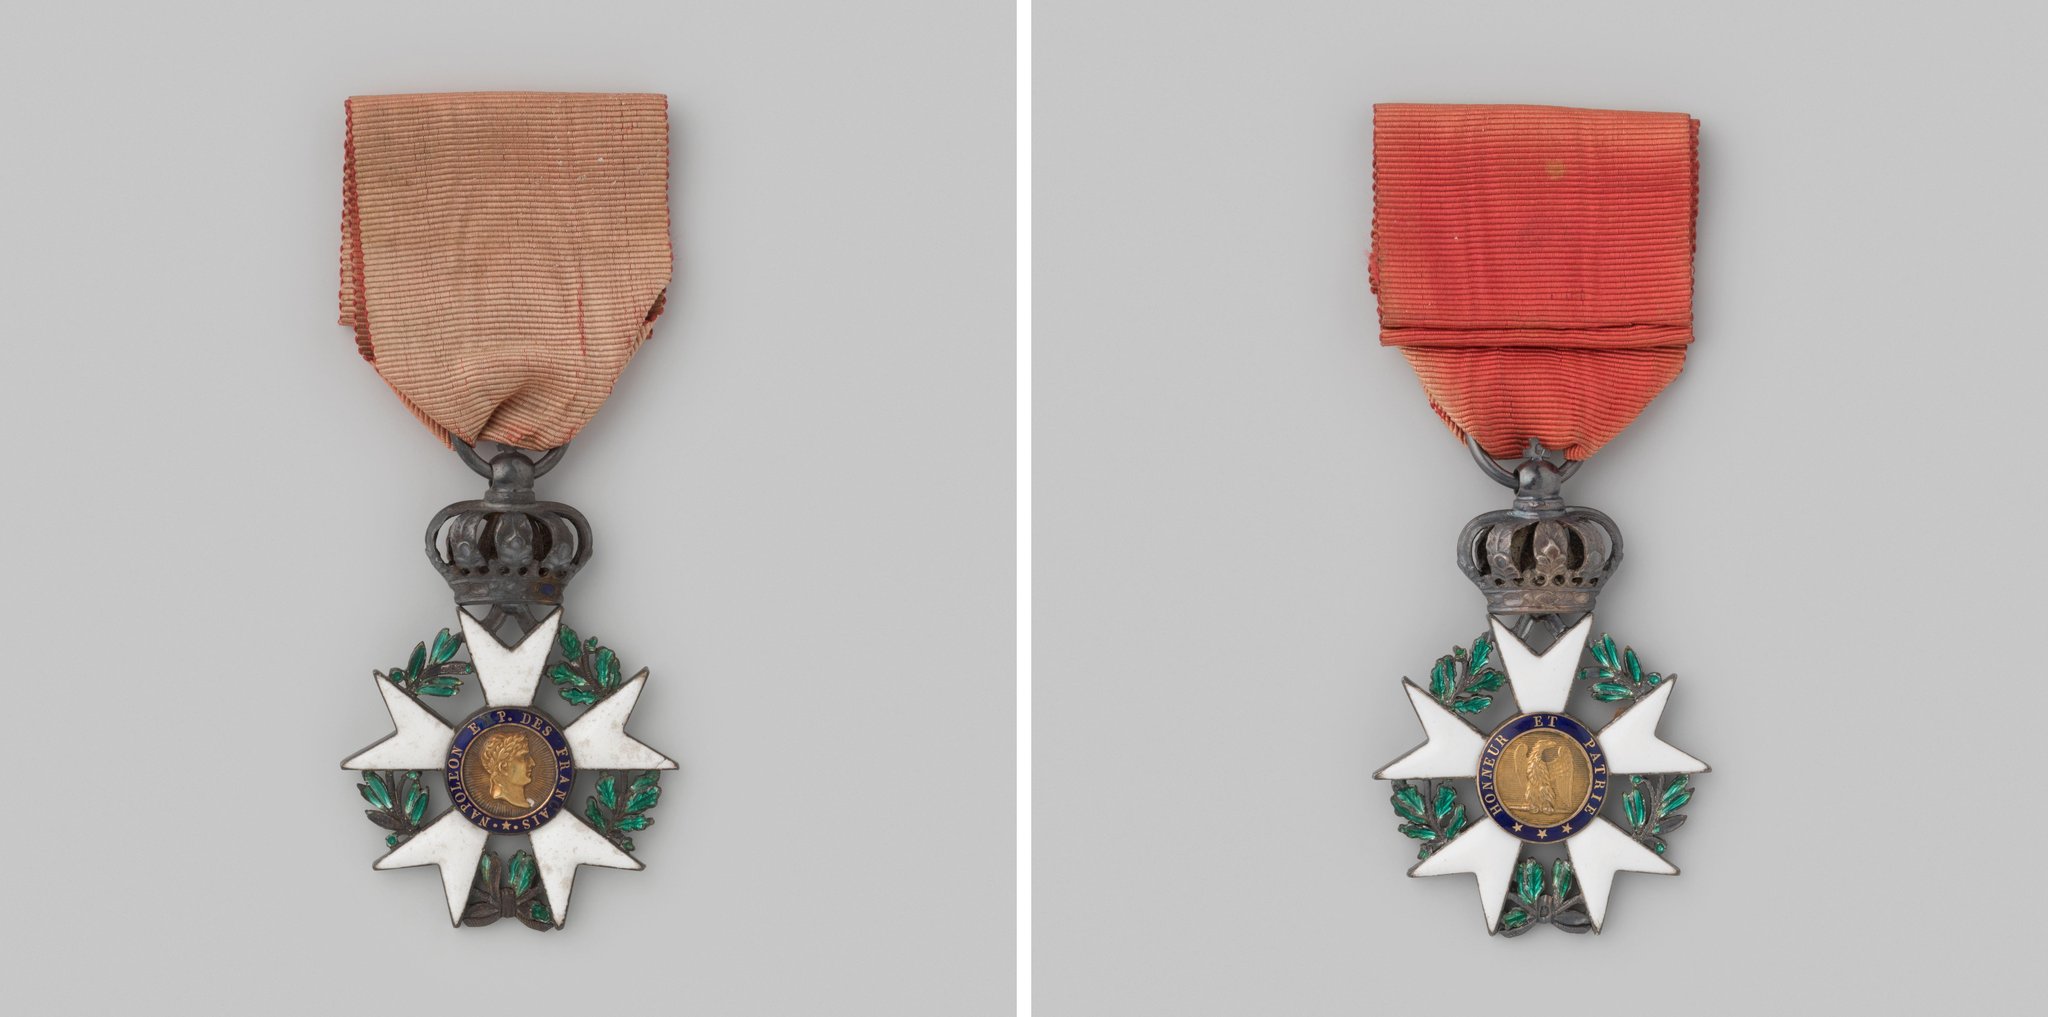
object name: honorary medal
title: Ridderkruis van het Legioen van Eer, toegekend aan generaal-majoor F.N.L. Aberson, commandant der schutterij te Amsterdam wegens deelname aan 17 veldtochten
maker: Anonymous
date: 1802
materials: metal, textile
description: Ereteken en draagpenning met oog, ring en lint, groot model.